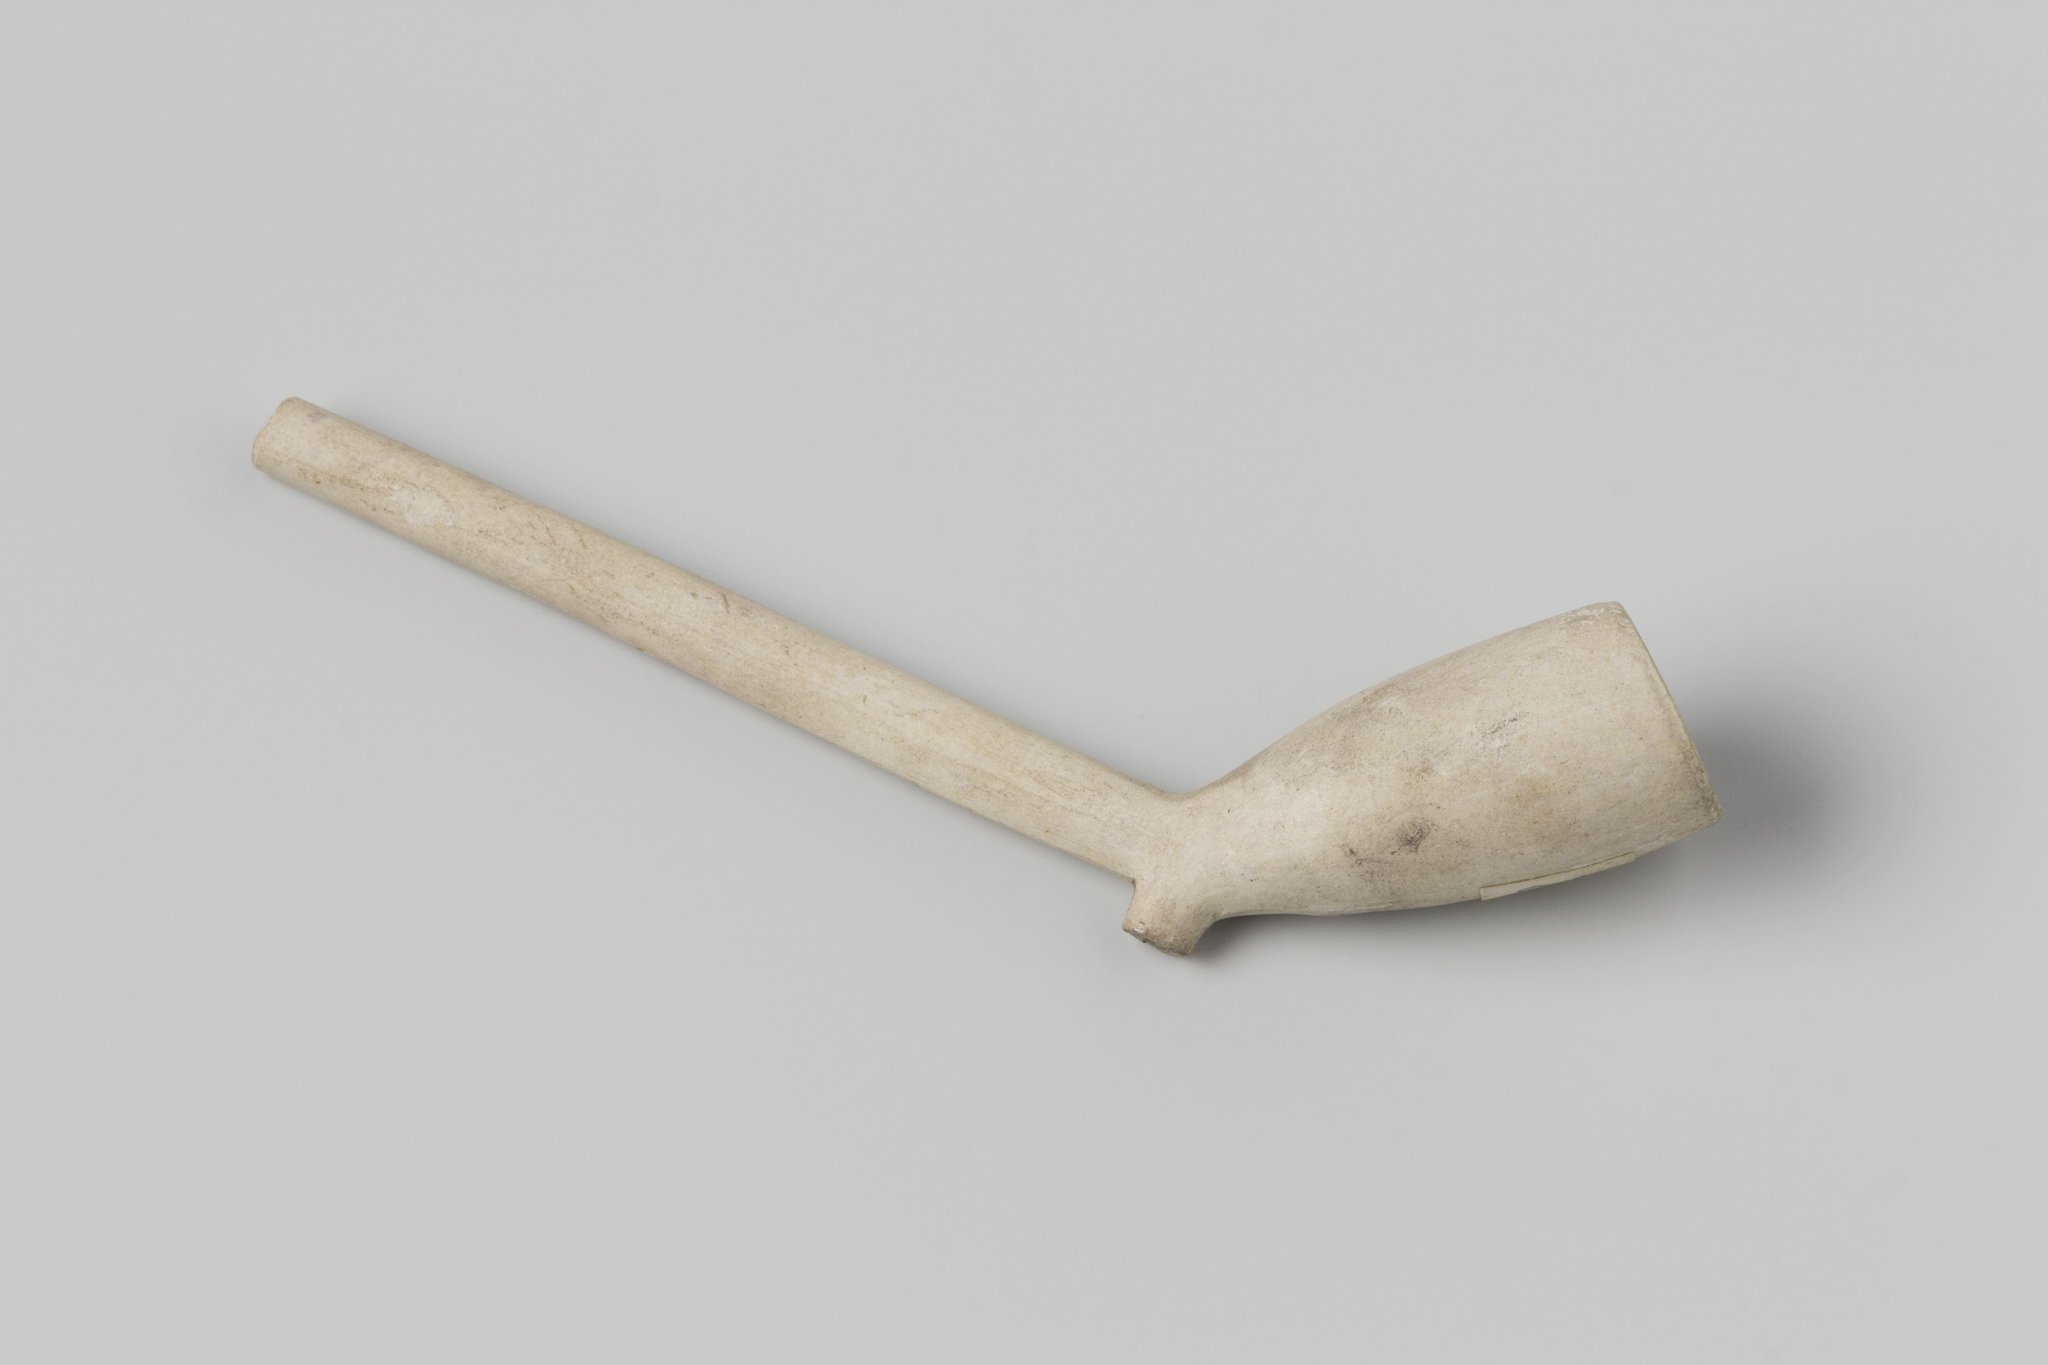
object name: tabakspijp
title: Tabakspijp.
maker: Anonymous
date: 1400-1950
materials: earthenware, clay